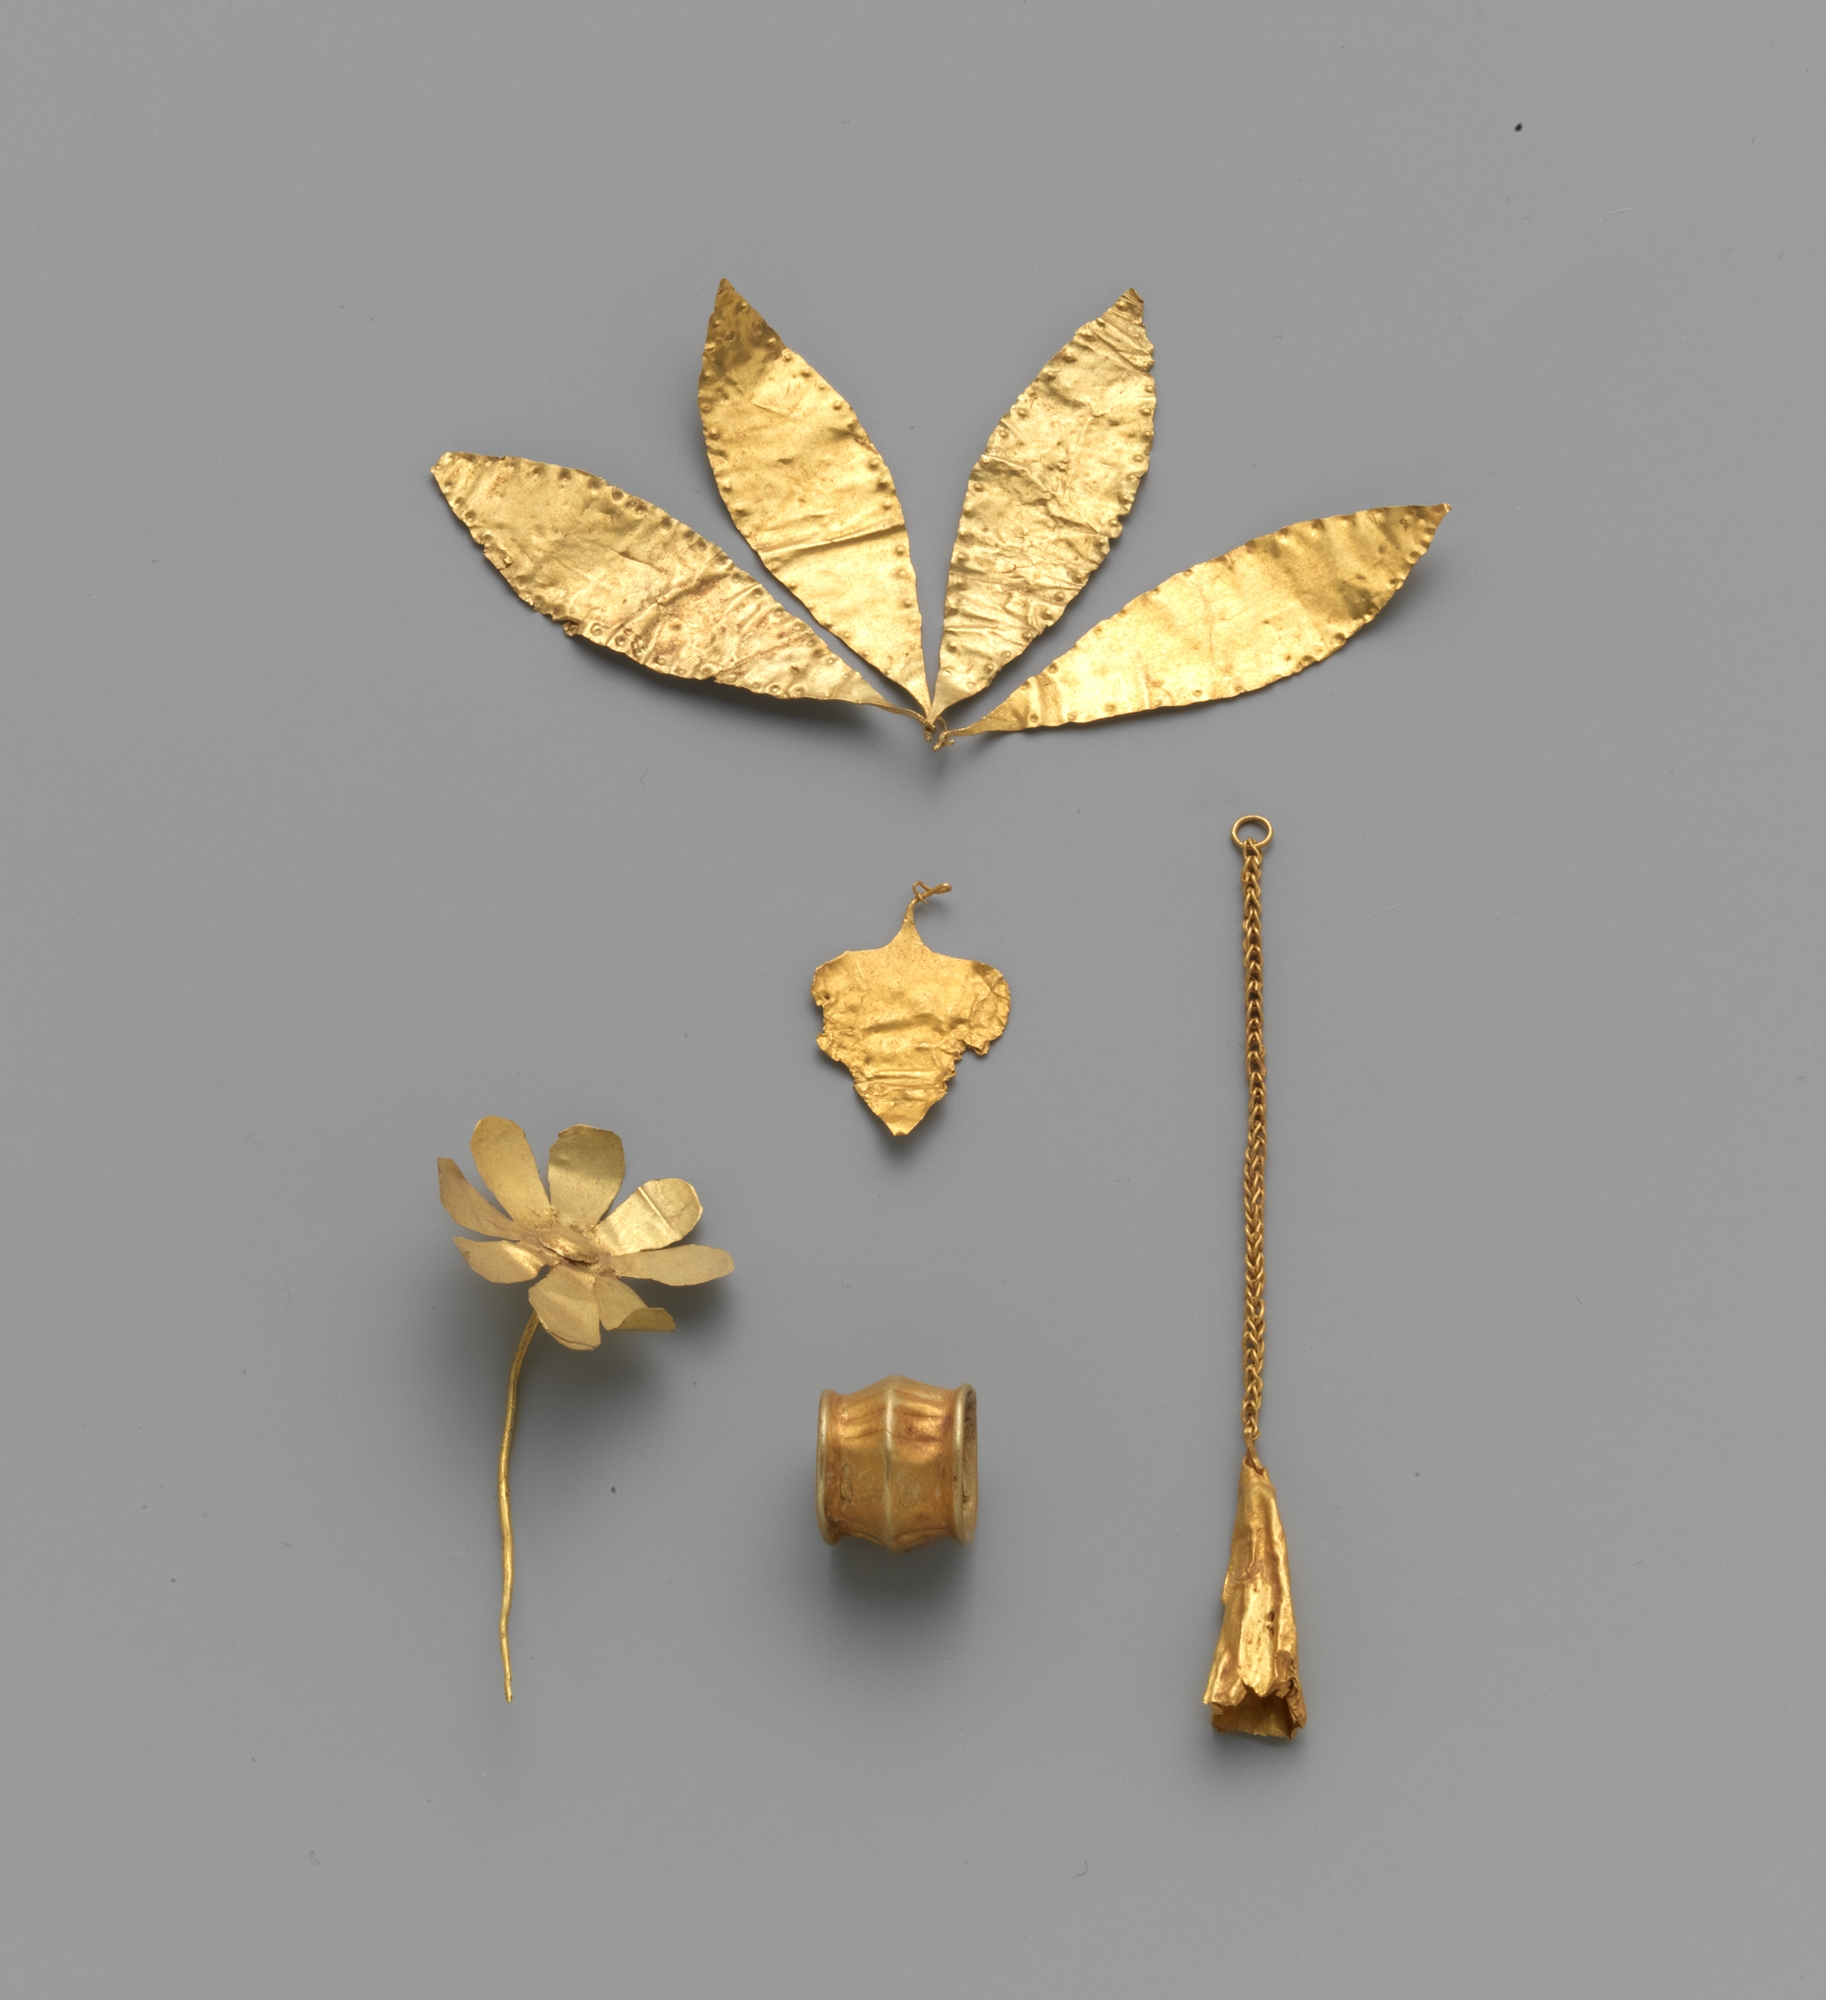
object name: pendant in the form of a leaf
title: Gold leaf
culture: minoan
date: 2300-2100 BCE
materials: gold